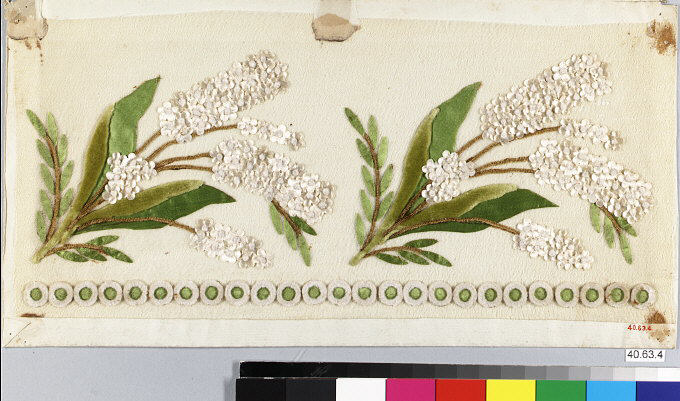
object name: border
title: Dress border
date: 1801-1833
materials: silk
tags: flowers